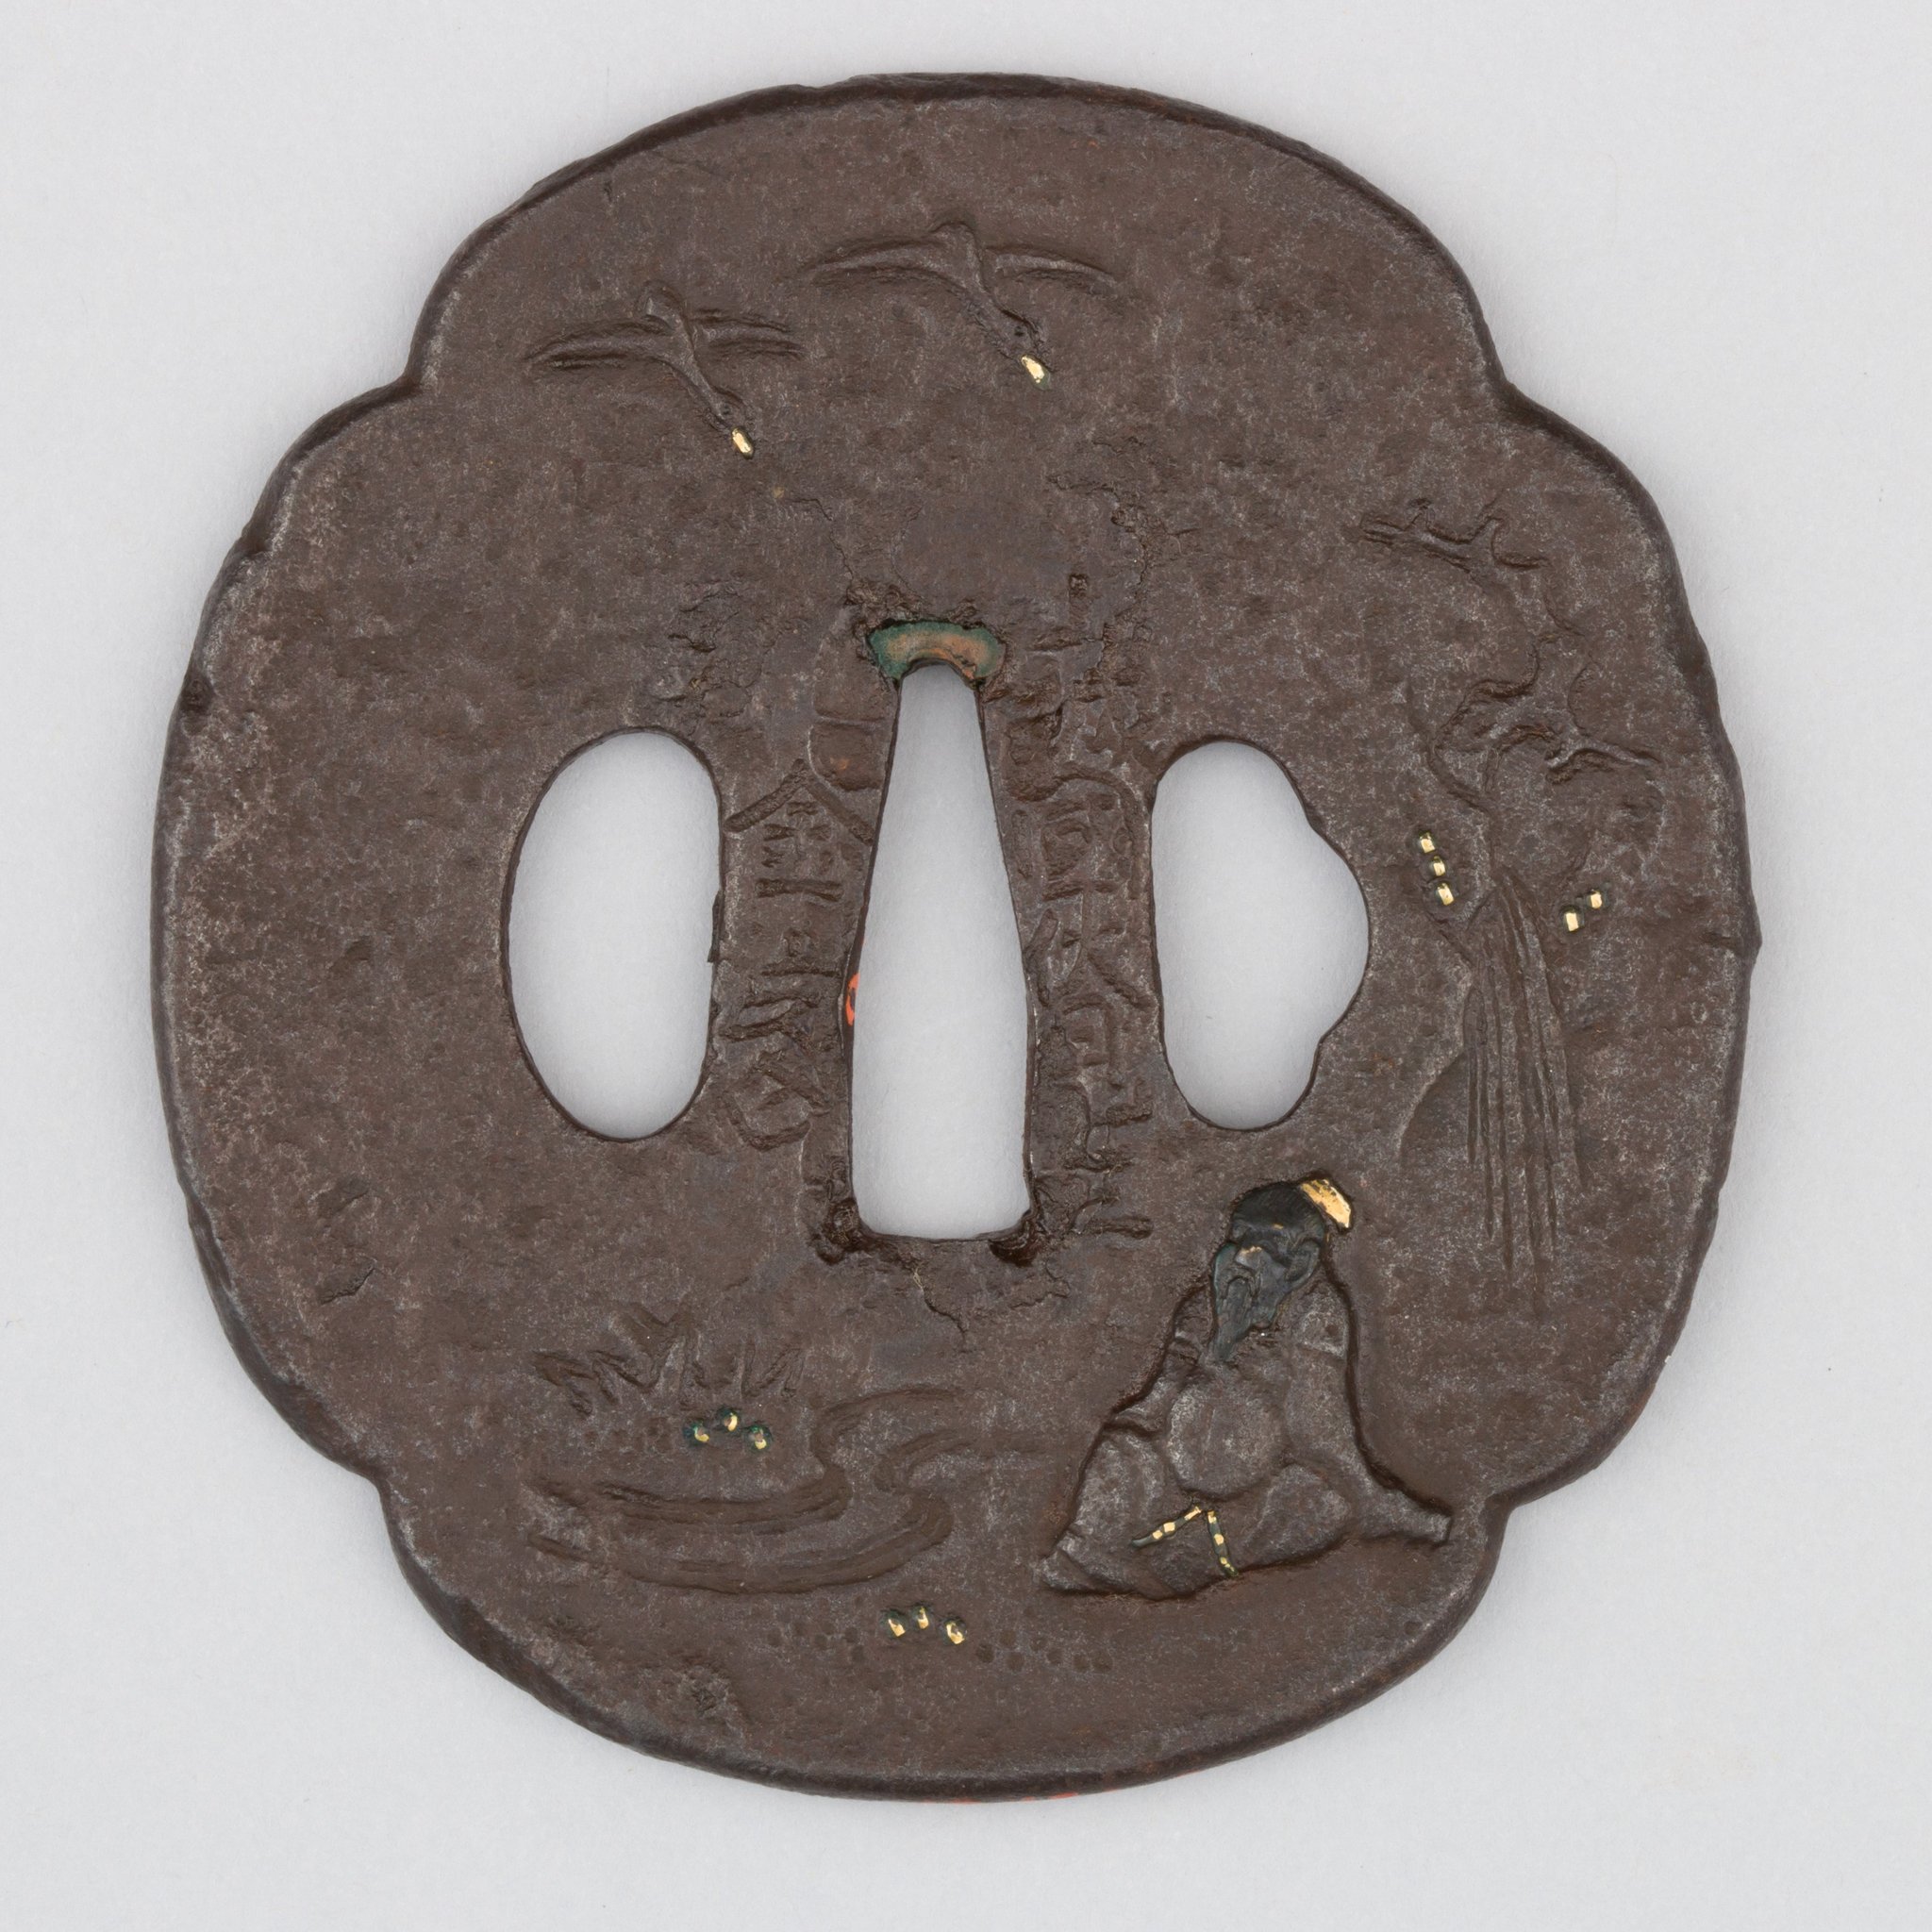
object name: sword guard tsuba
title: Sword Guard (Tsuba)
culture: japanese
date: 1701-1800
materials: copper, gold, iron, silver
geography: japan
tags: birds,men